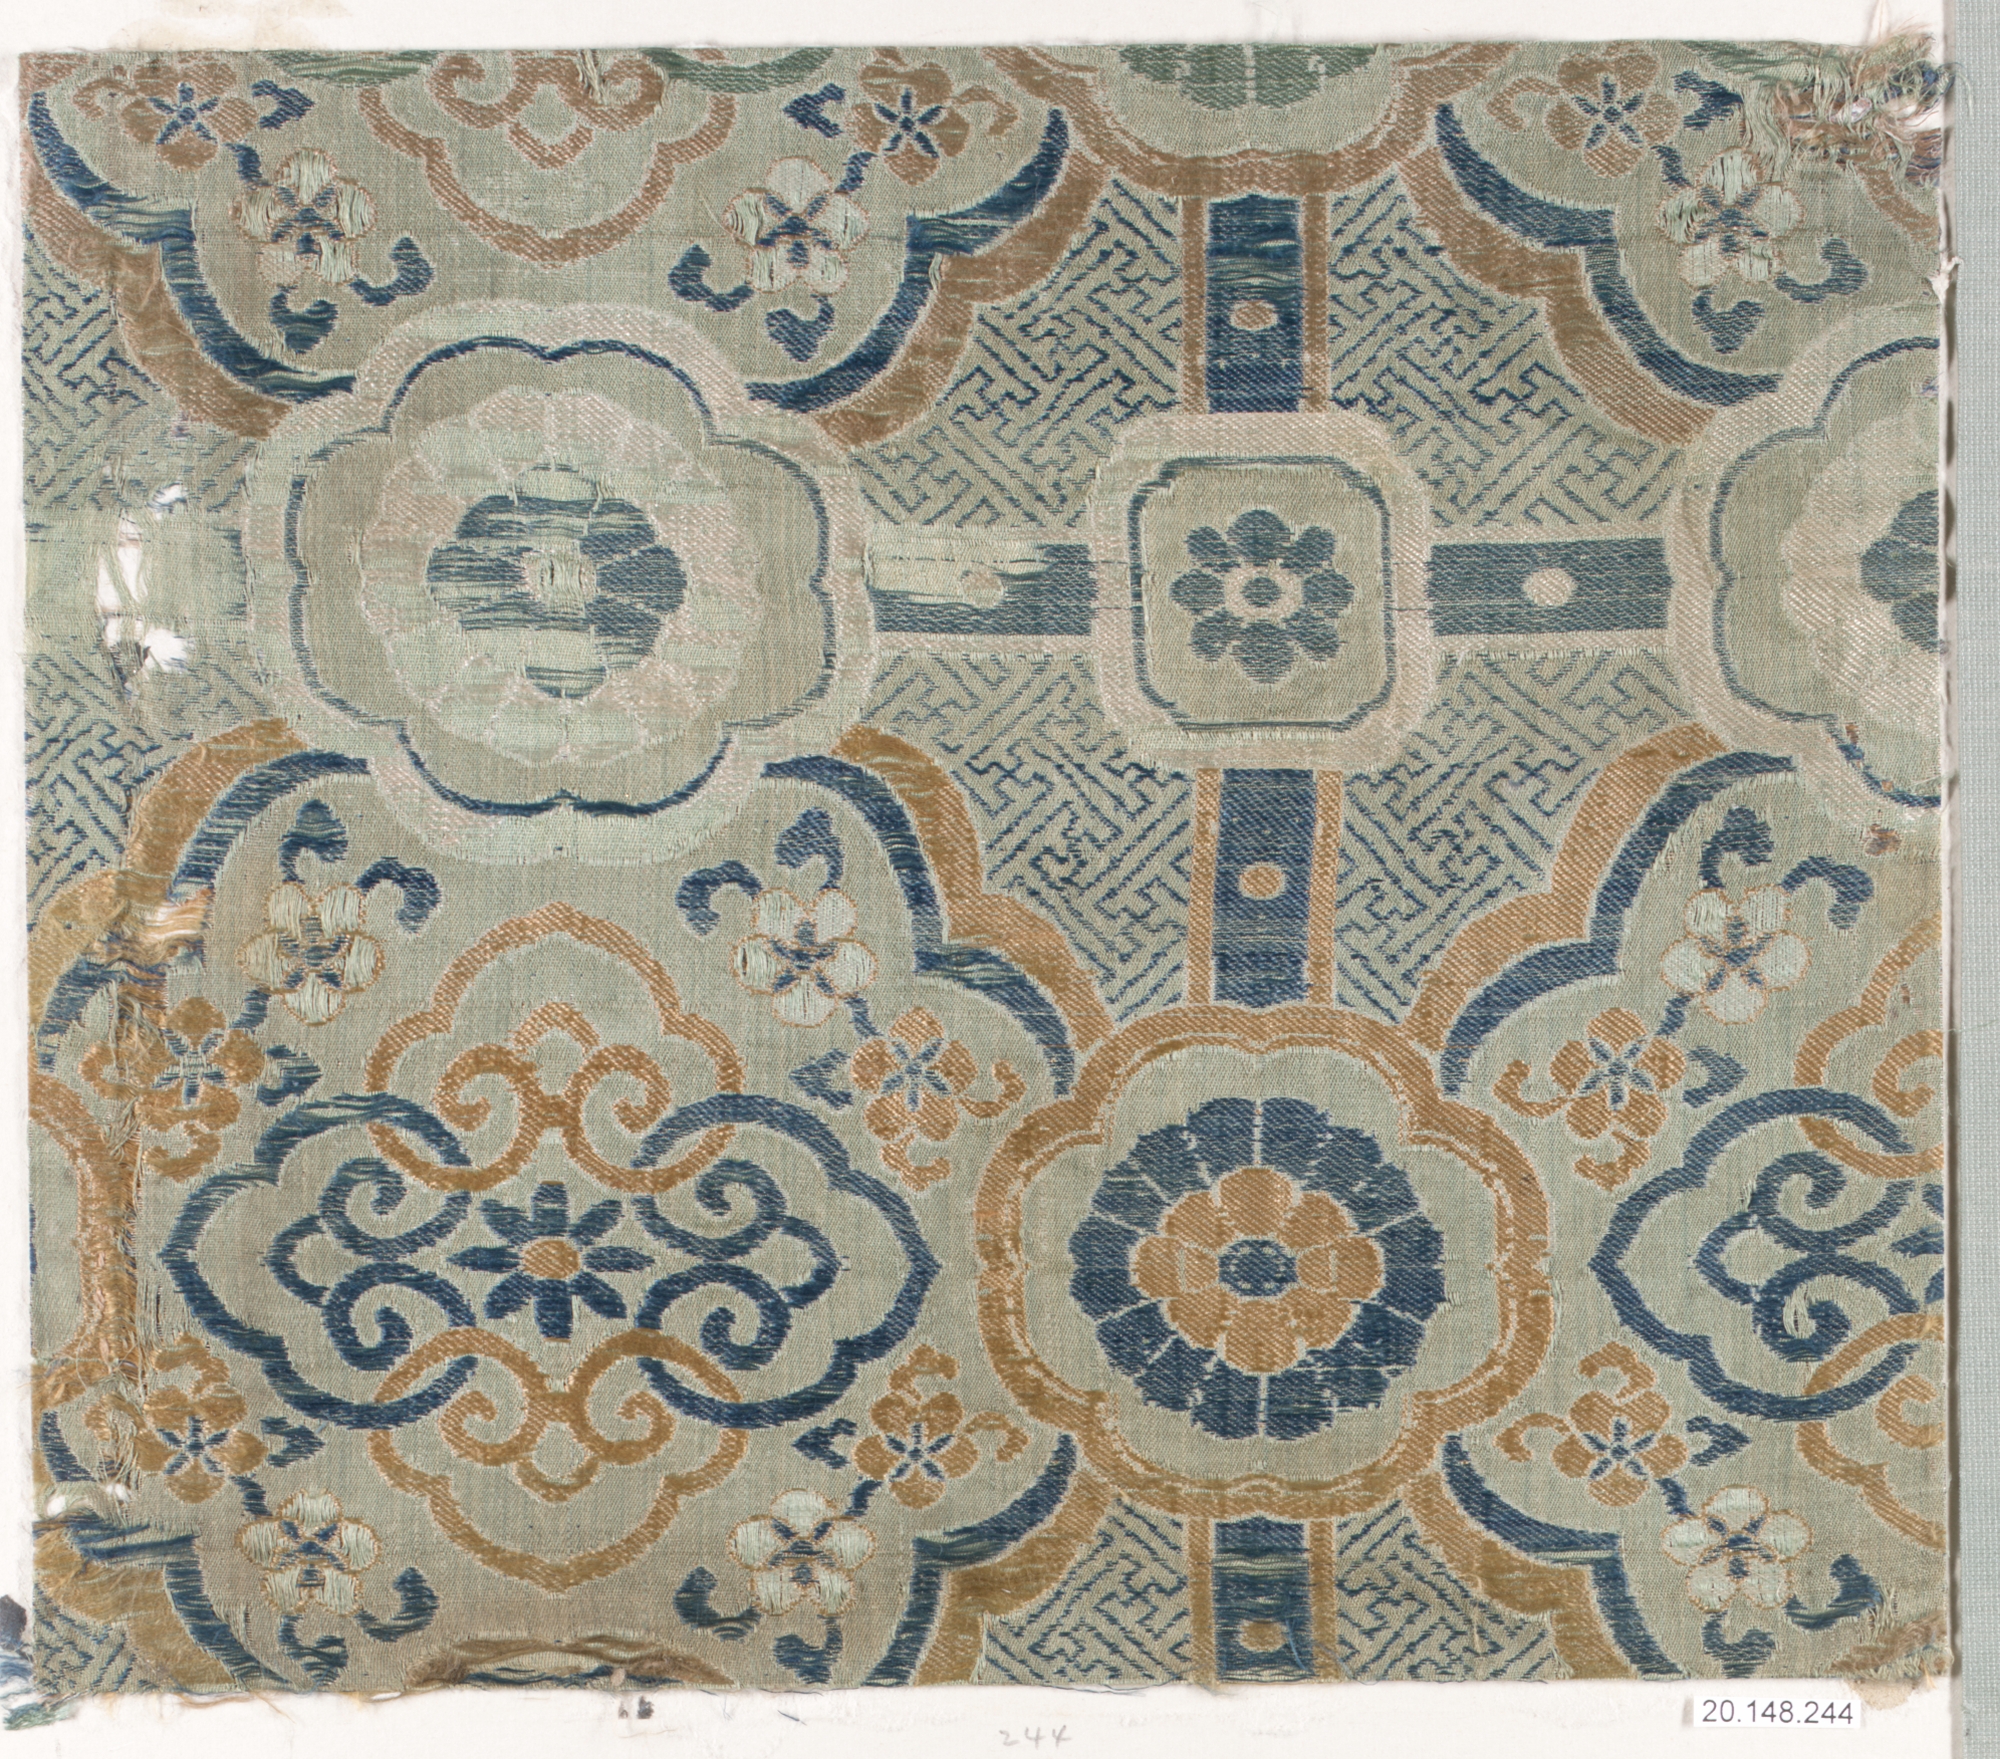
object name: piece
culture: chinese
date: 1601-1700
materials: silk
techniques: compound weave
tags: flowers